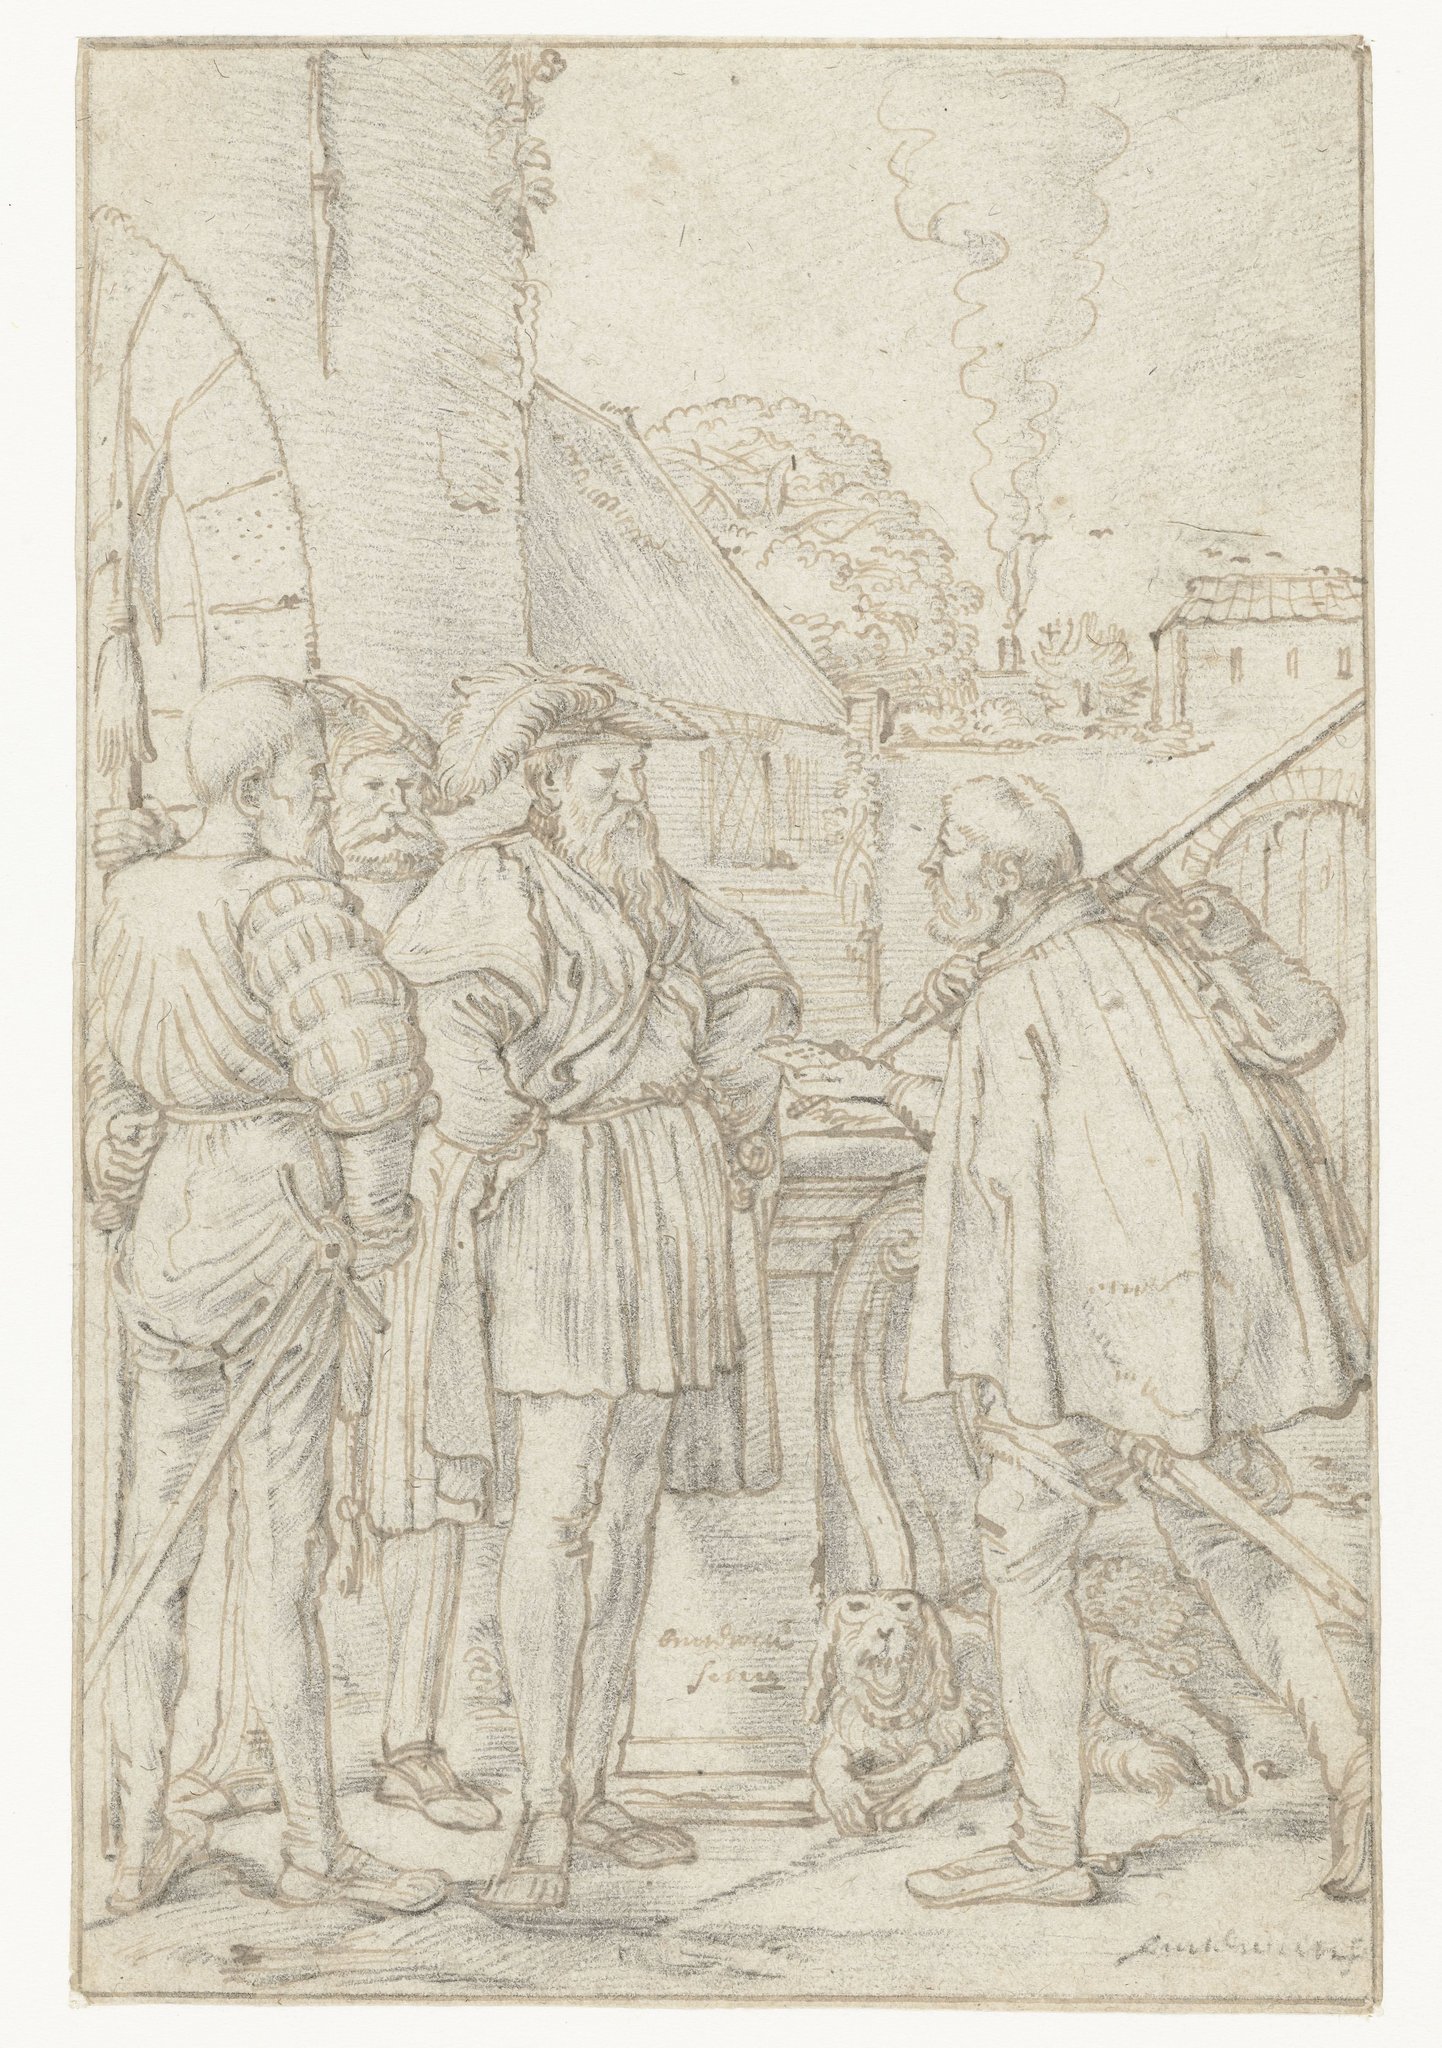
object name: drawing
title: De rechtspraak van Graaf Willem III de Goede, tweede reeks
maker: willem pietersz buytewech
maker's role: draughtsman, print maker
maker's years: 1592-1624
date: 1619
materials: chalk, ink, paper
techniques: pen